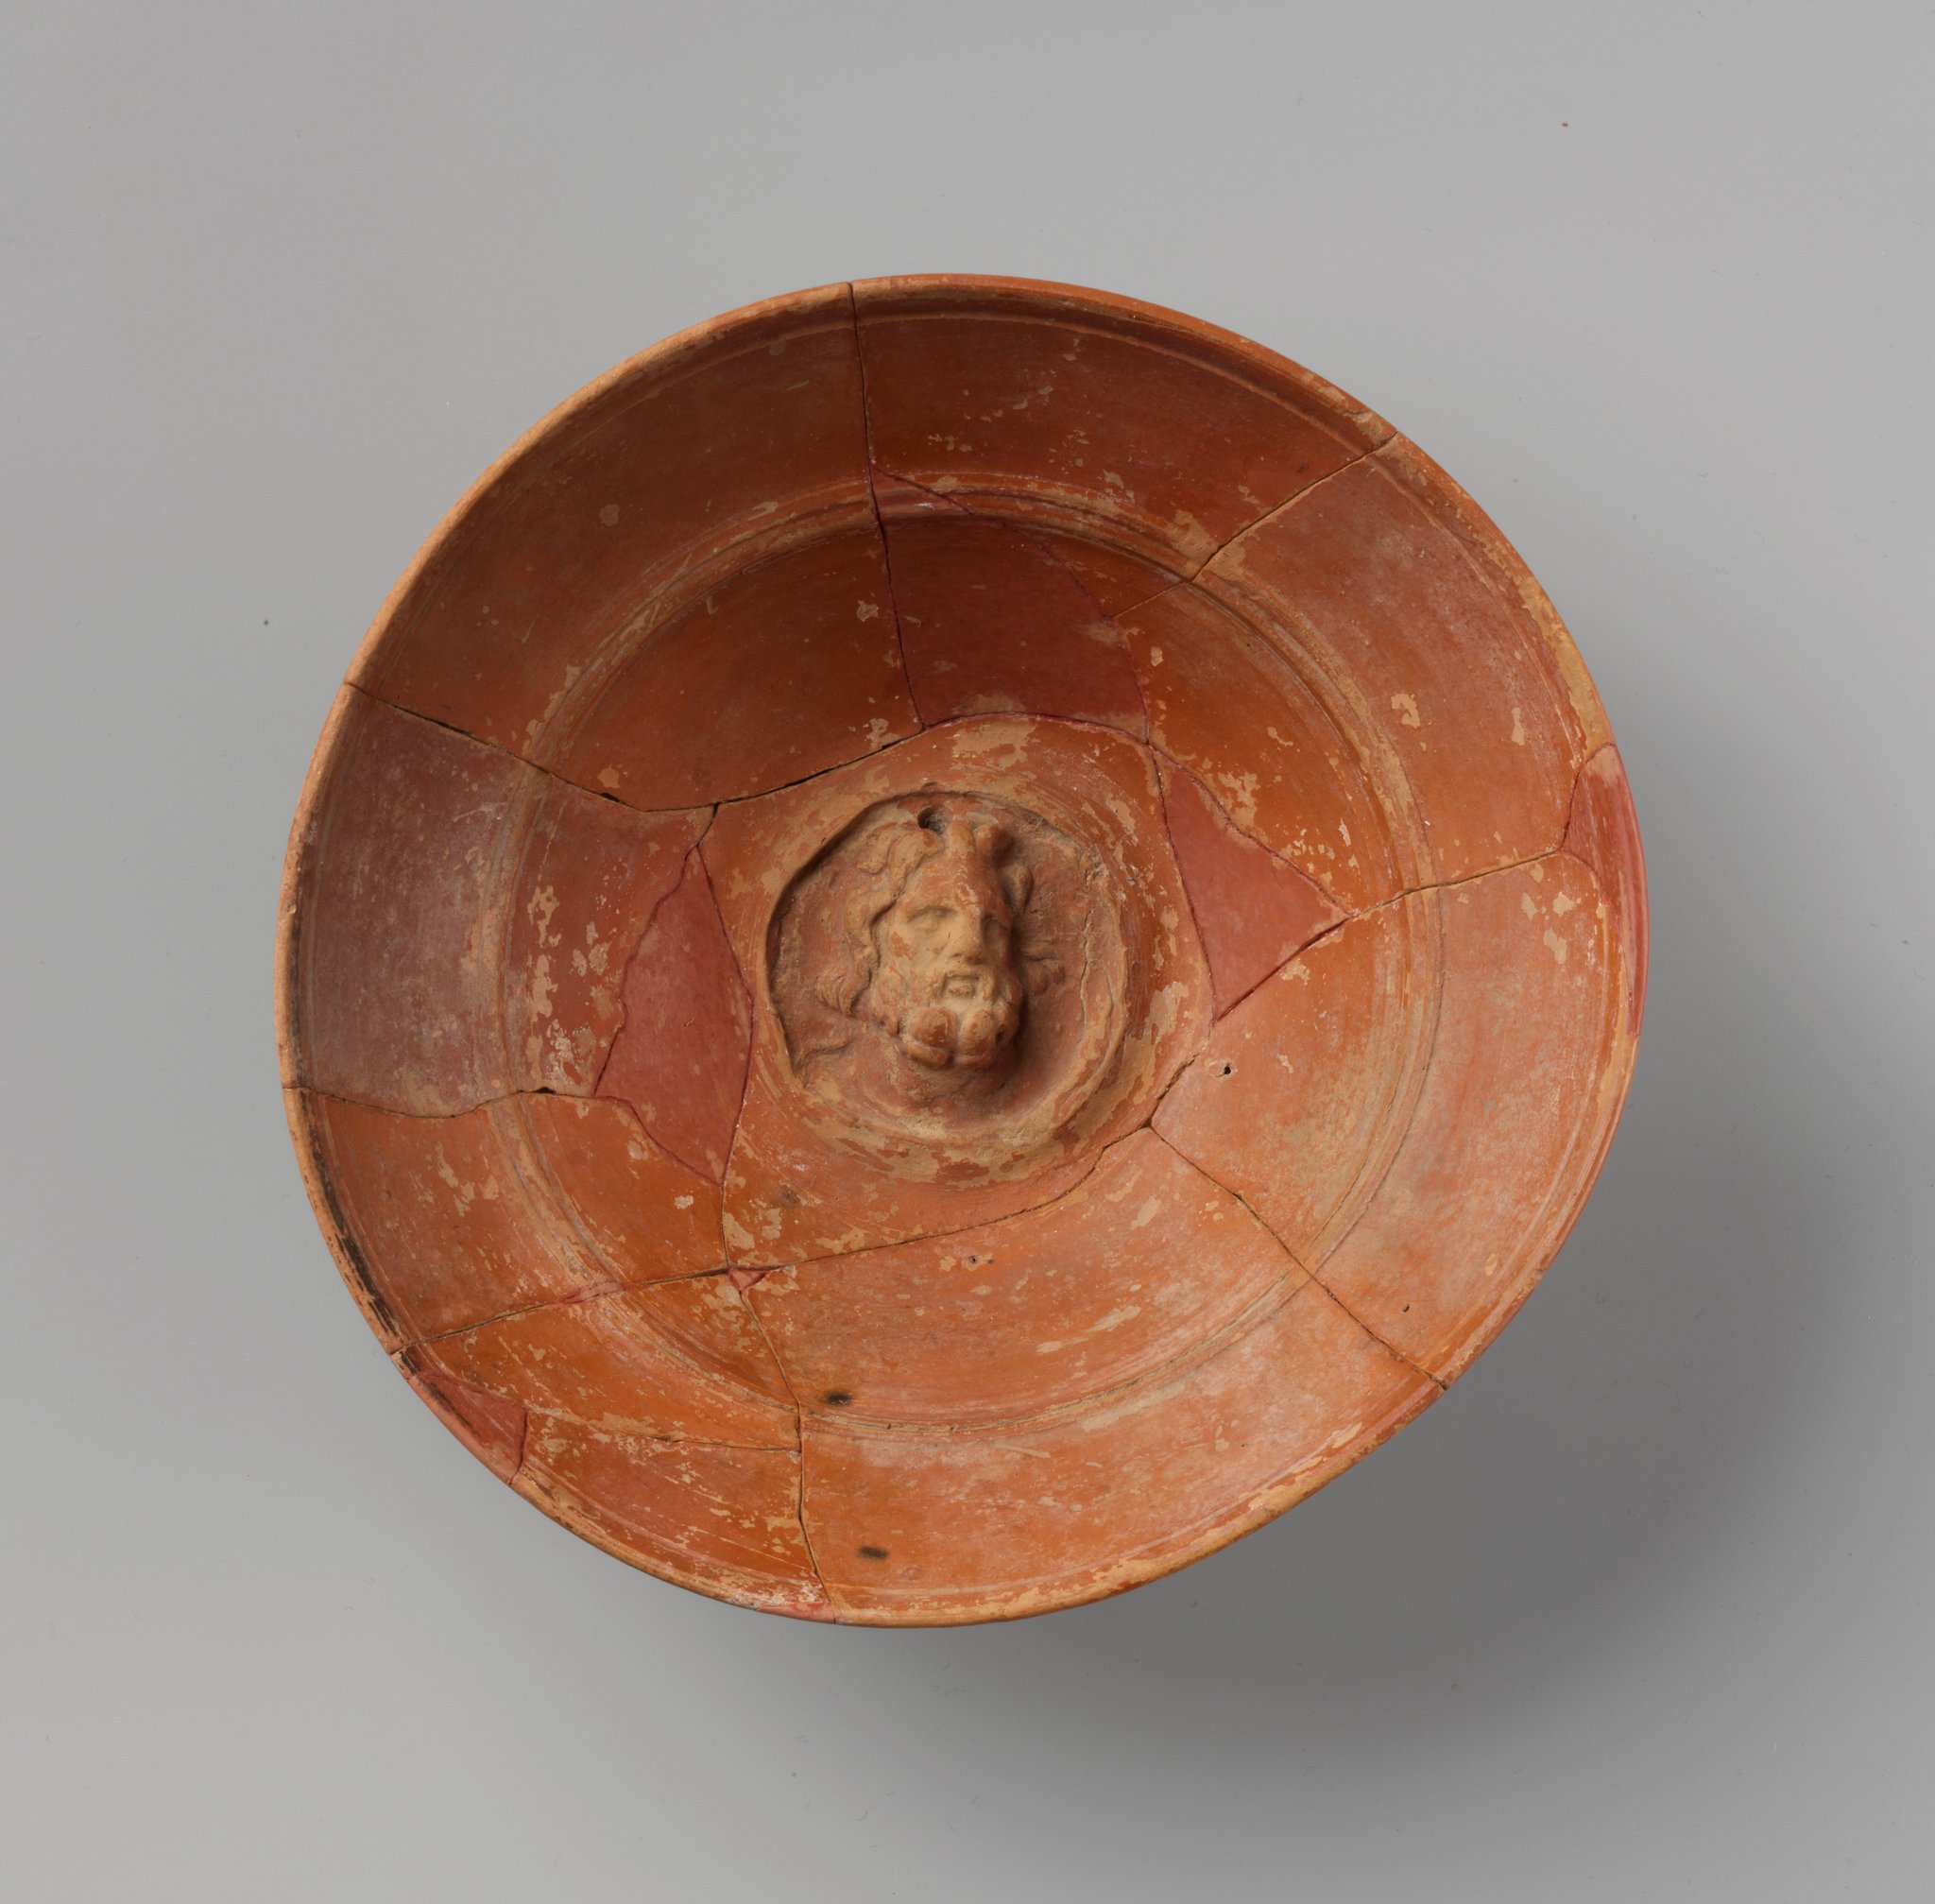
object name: bowl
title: Terracotta emblem bowl with head of Zeus or Sarapis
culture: greek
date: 300-1 BCE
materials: terracotta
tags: heads,men